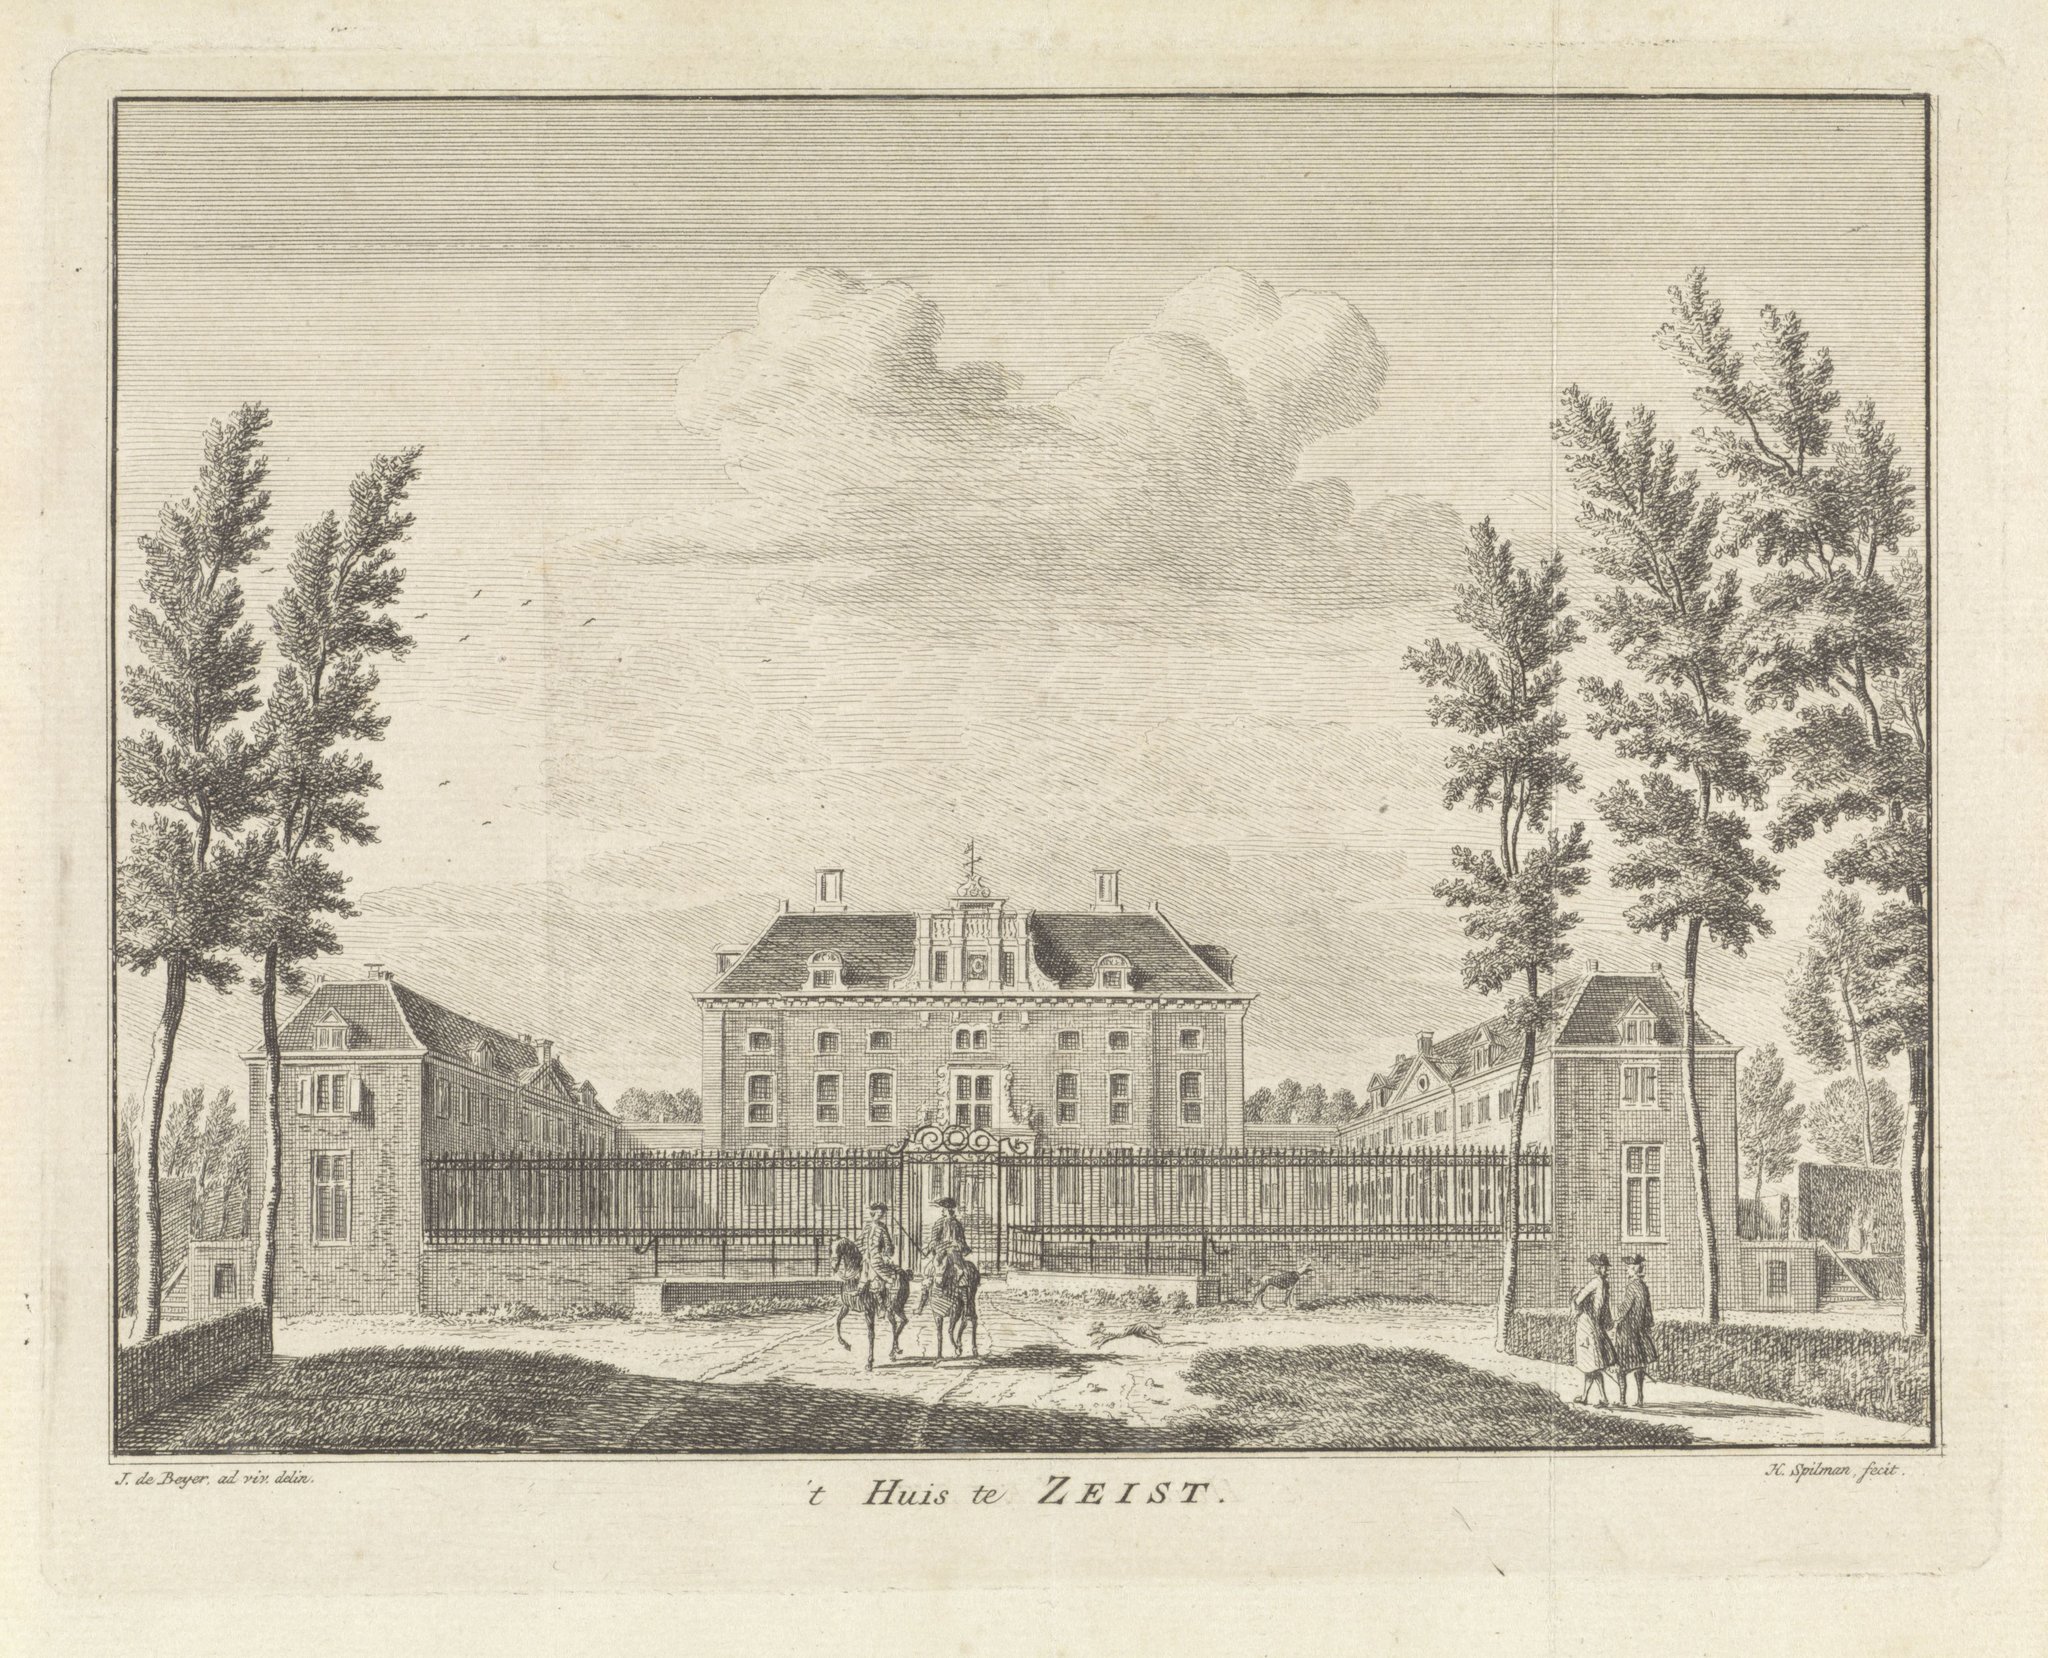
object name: print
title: 't Huis te Zeist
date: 1742-1784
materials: paper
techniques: etching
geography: haarlem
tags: riding a horse, ass, or mule; rider, horseman, palace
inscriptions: collector's mark: Lugt 2228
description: Twee ruiters en twee mannen voor slot Zeist.